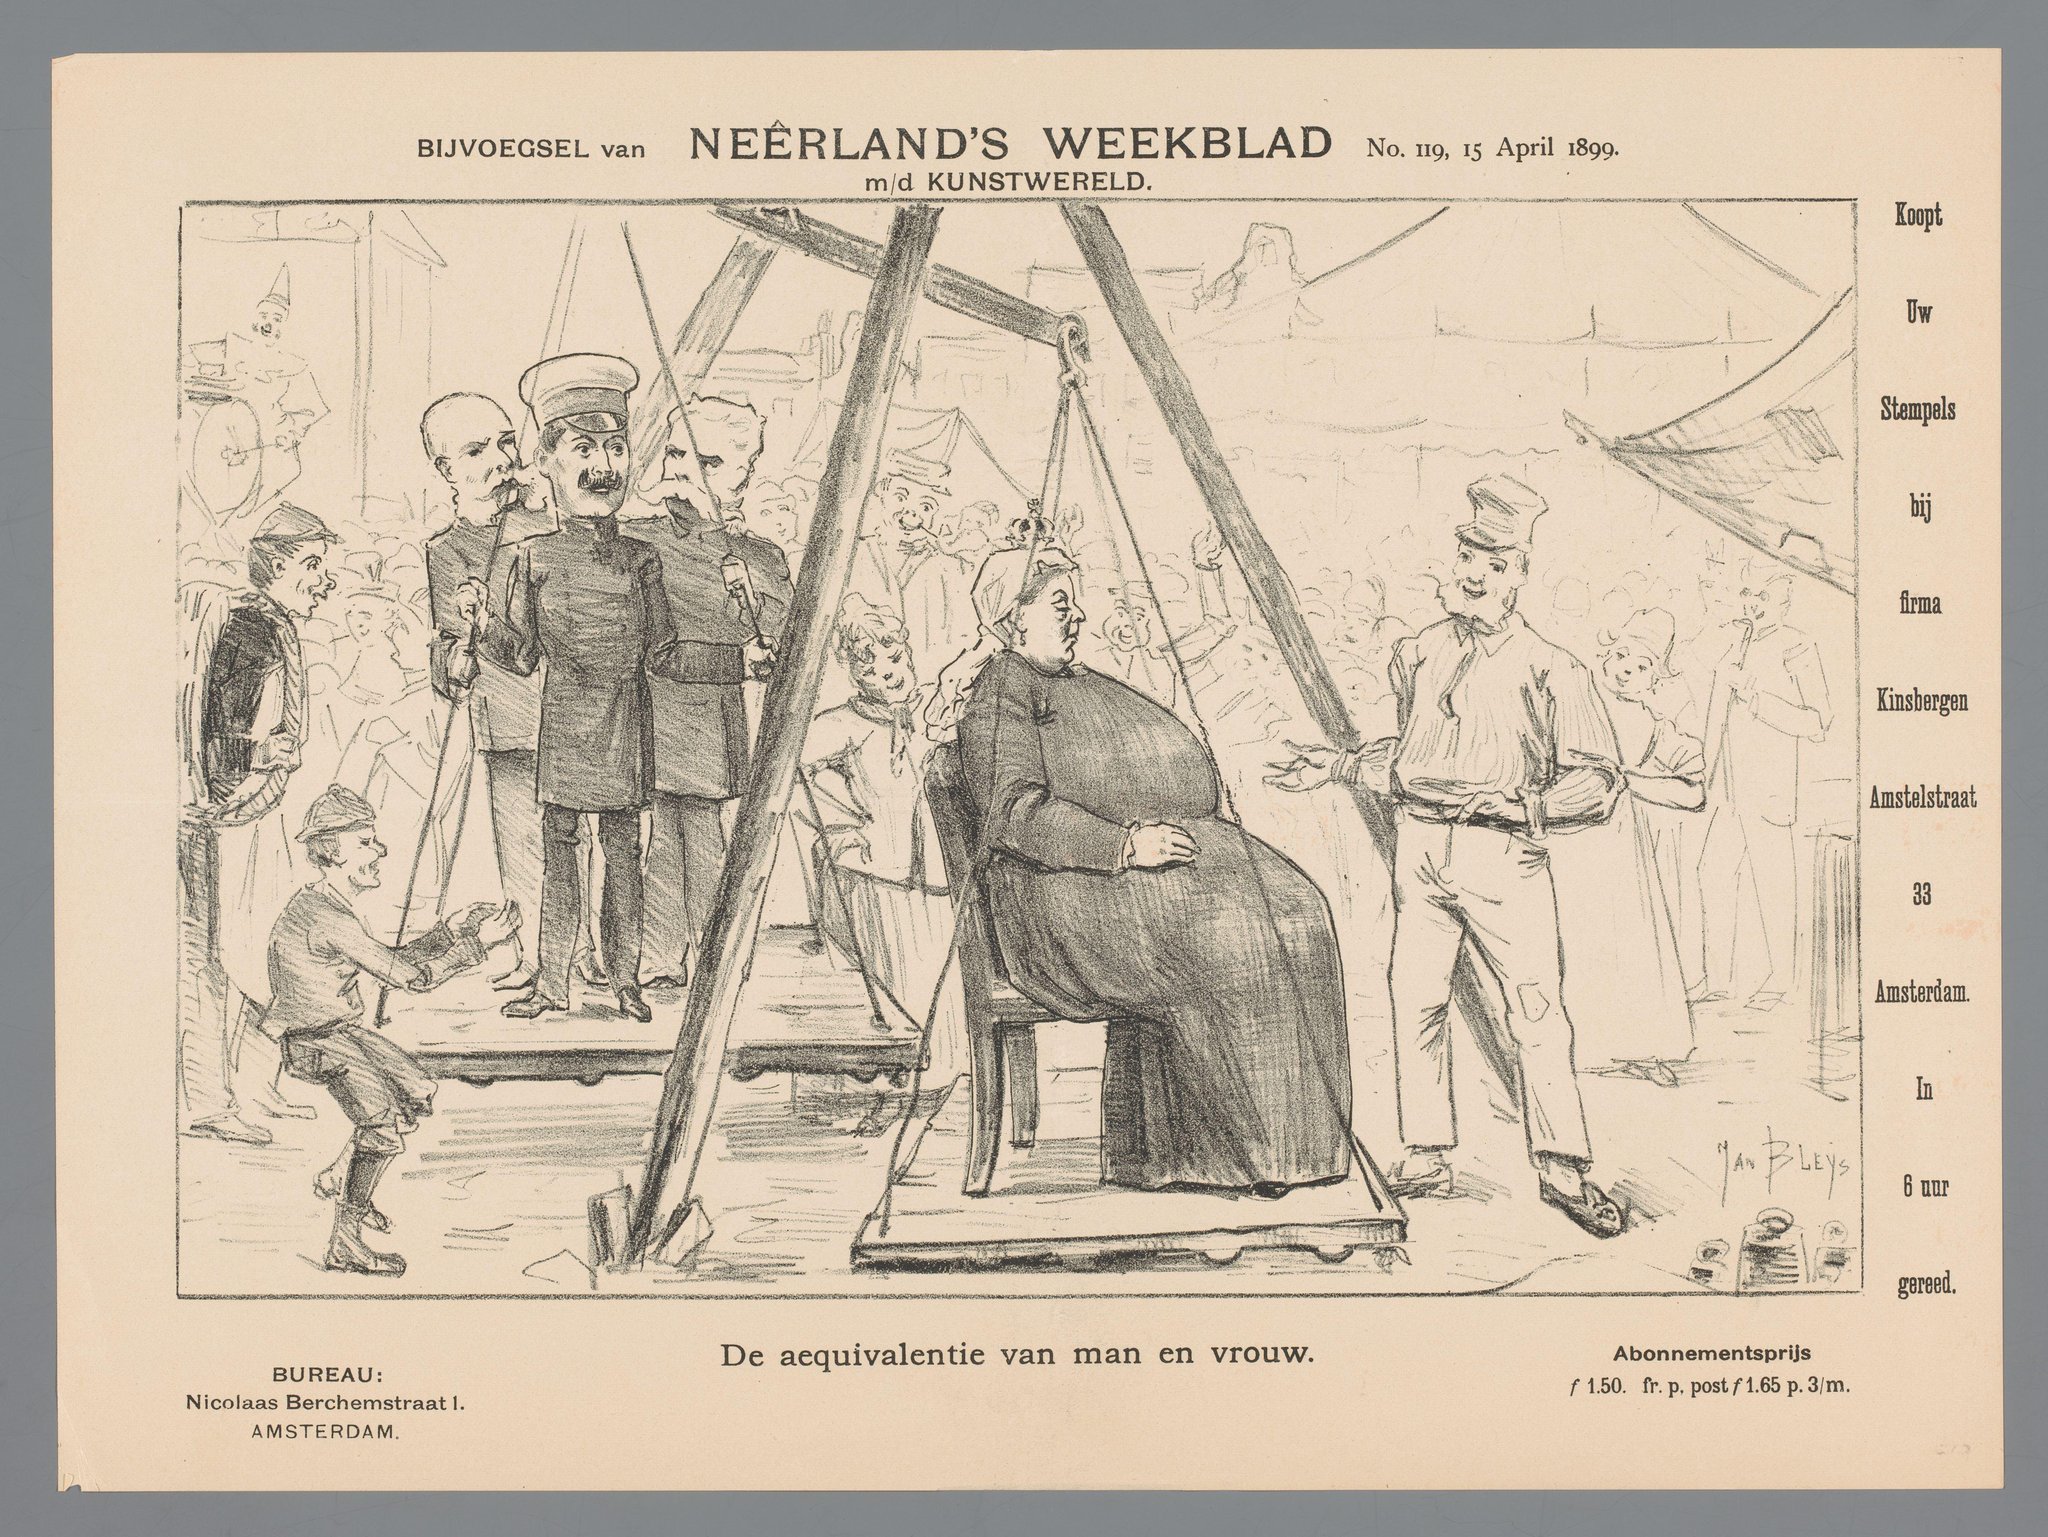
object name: cartoon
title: De aequivalentie van man en vrouw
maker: jan bleijs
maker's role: draughtsman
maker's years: 1868-1952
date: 1899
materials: paper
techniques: lithograph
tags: victoria (koningin van het verenigd koninkrijk en keizerin van india), historical persons, scales, political caricatures and satires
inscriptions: date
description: Prent uit het bijvoegsel van: Neêrland’s Weekblad, nr. 119, 15 april 1899.